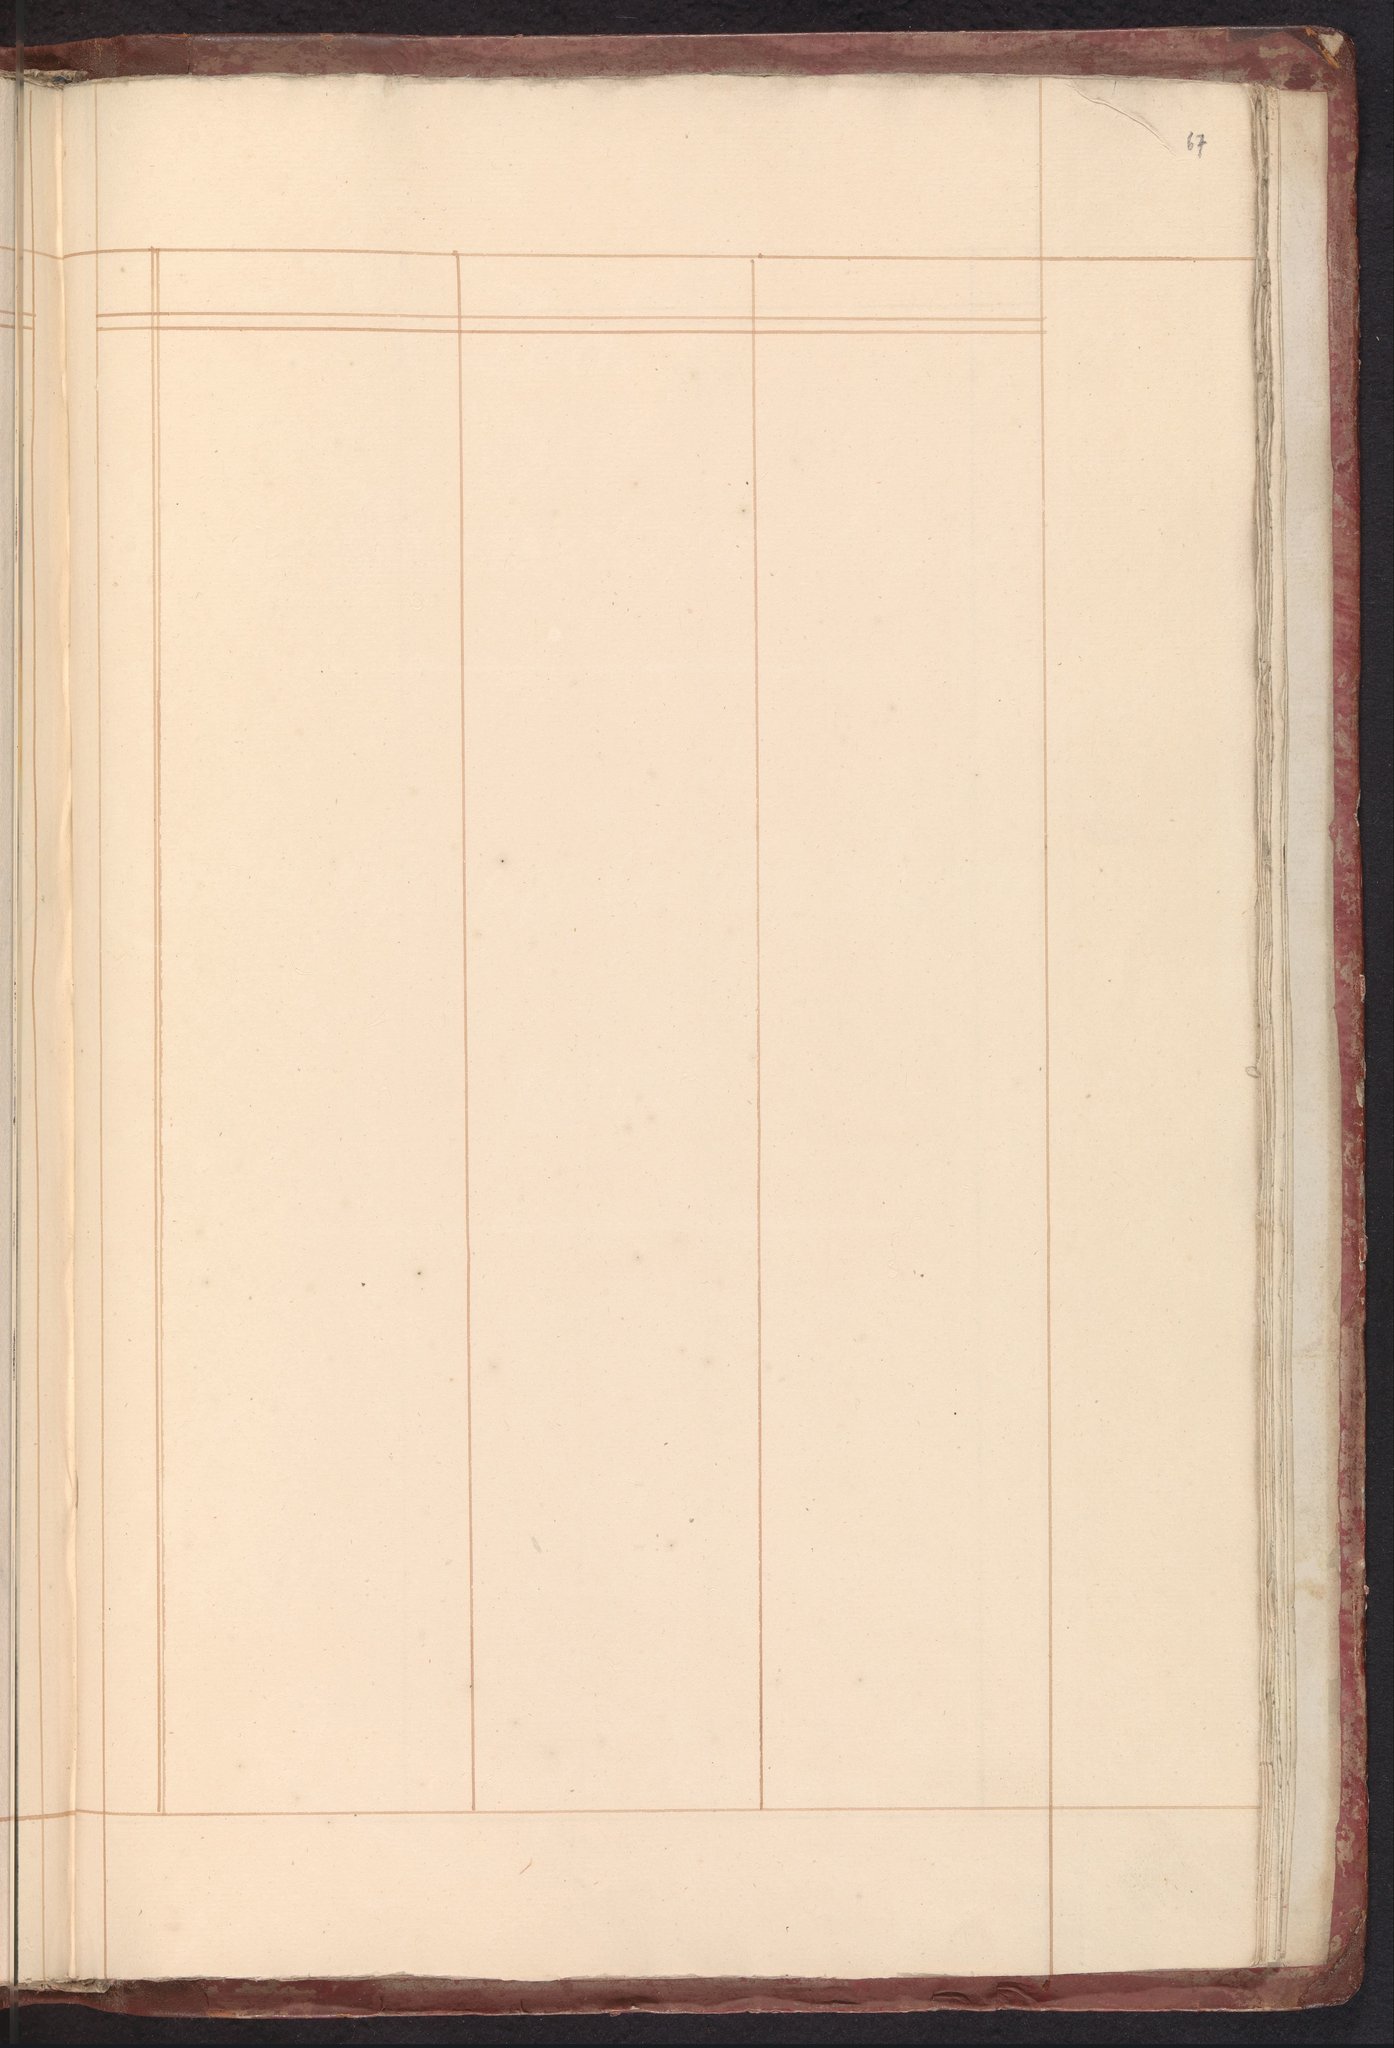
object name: manuscript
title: Oningevuld schema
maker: joseph van huerne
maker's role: kunstliefhebber, mecenas, verzamelaar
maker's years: 1752-1844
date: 1809-1814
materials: ink, paper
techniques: pen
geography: bruges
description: Oningevuld schema met drie kolommen. Onderdeel van het tweede album met tekeningen van viervoeters. Tweede van twaalf albums met tekeningen van dieren, vogels en planten bekend rond 1600, gemaakt in opdracht van keizer Rudolf II. Met toelichting in Nederlands, Latijn en Frans.